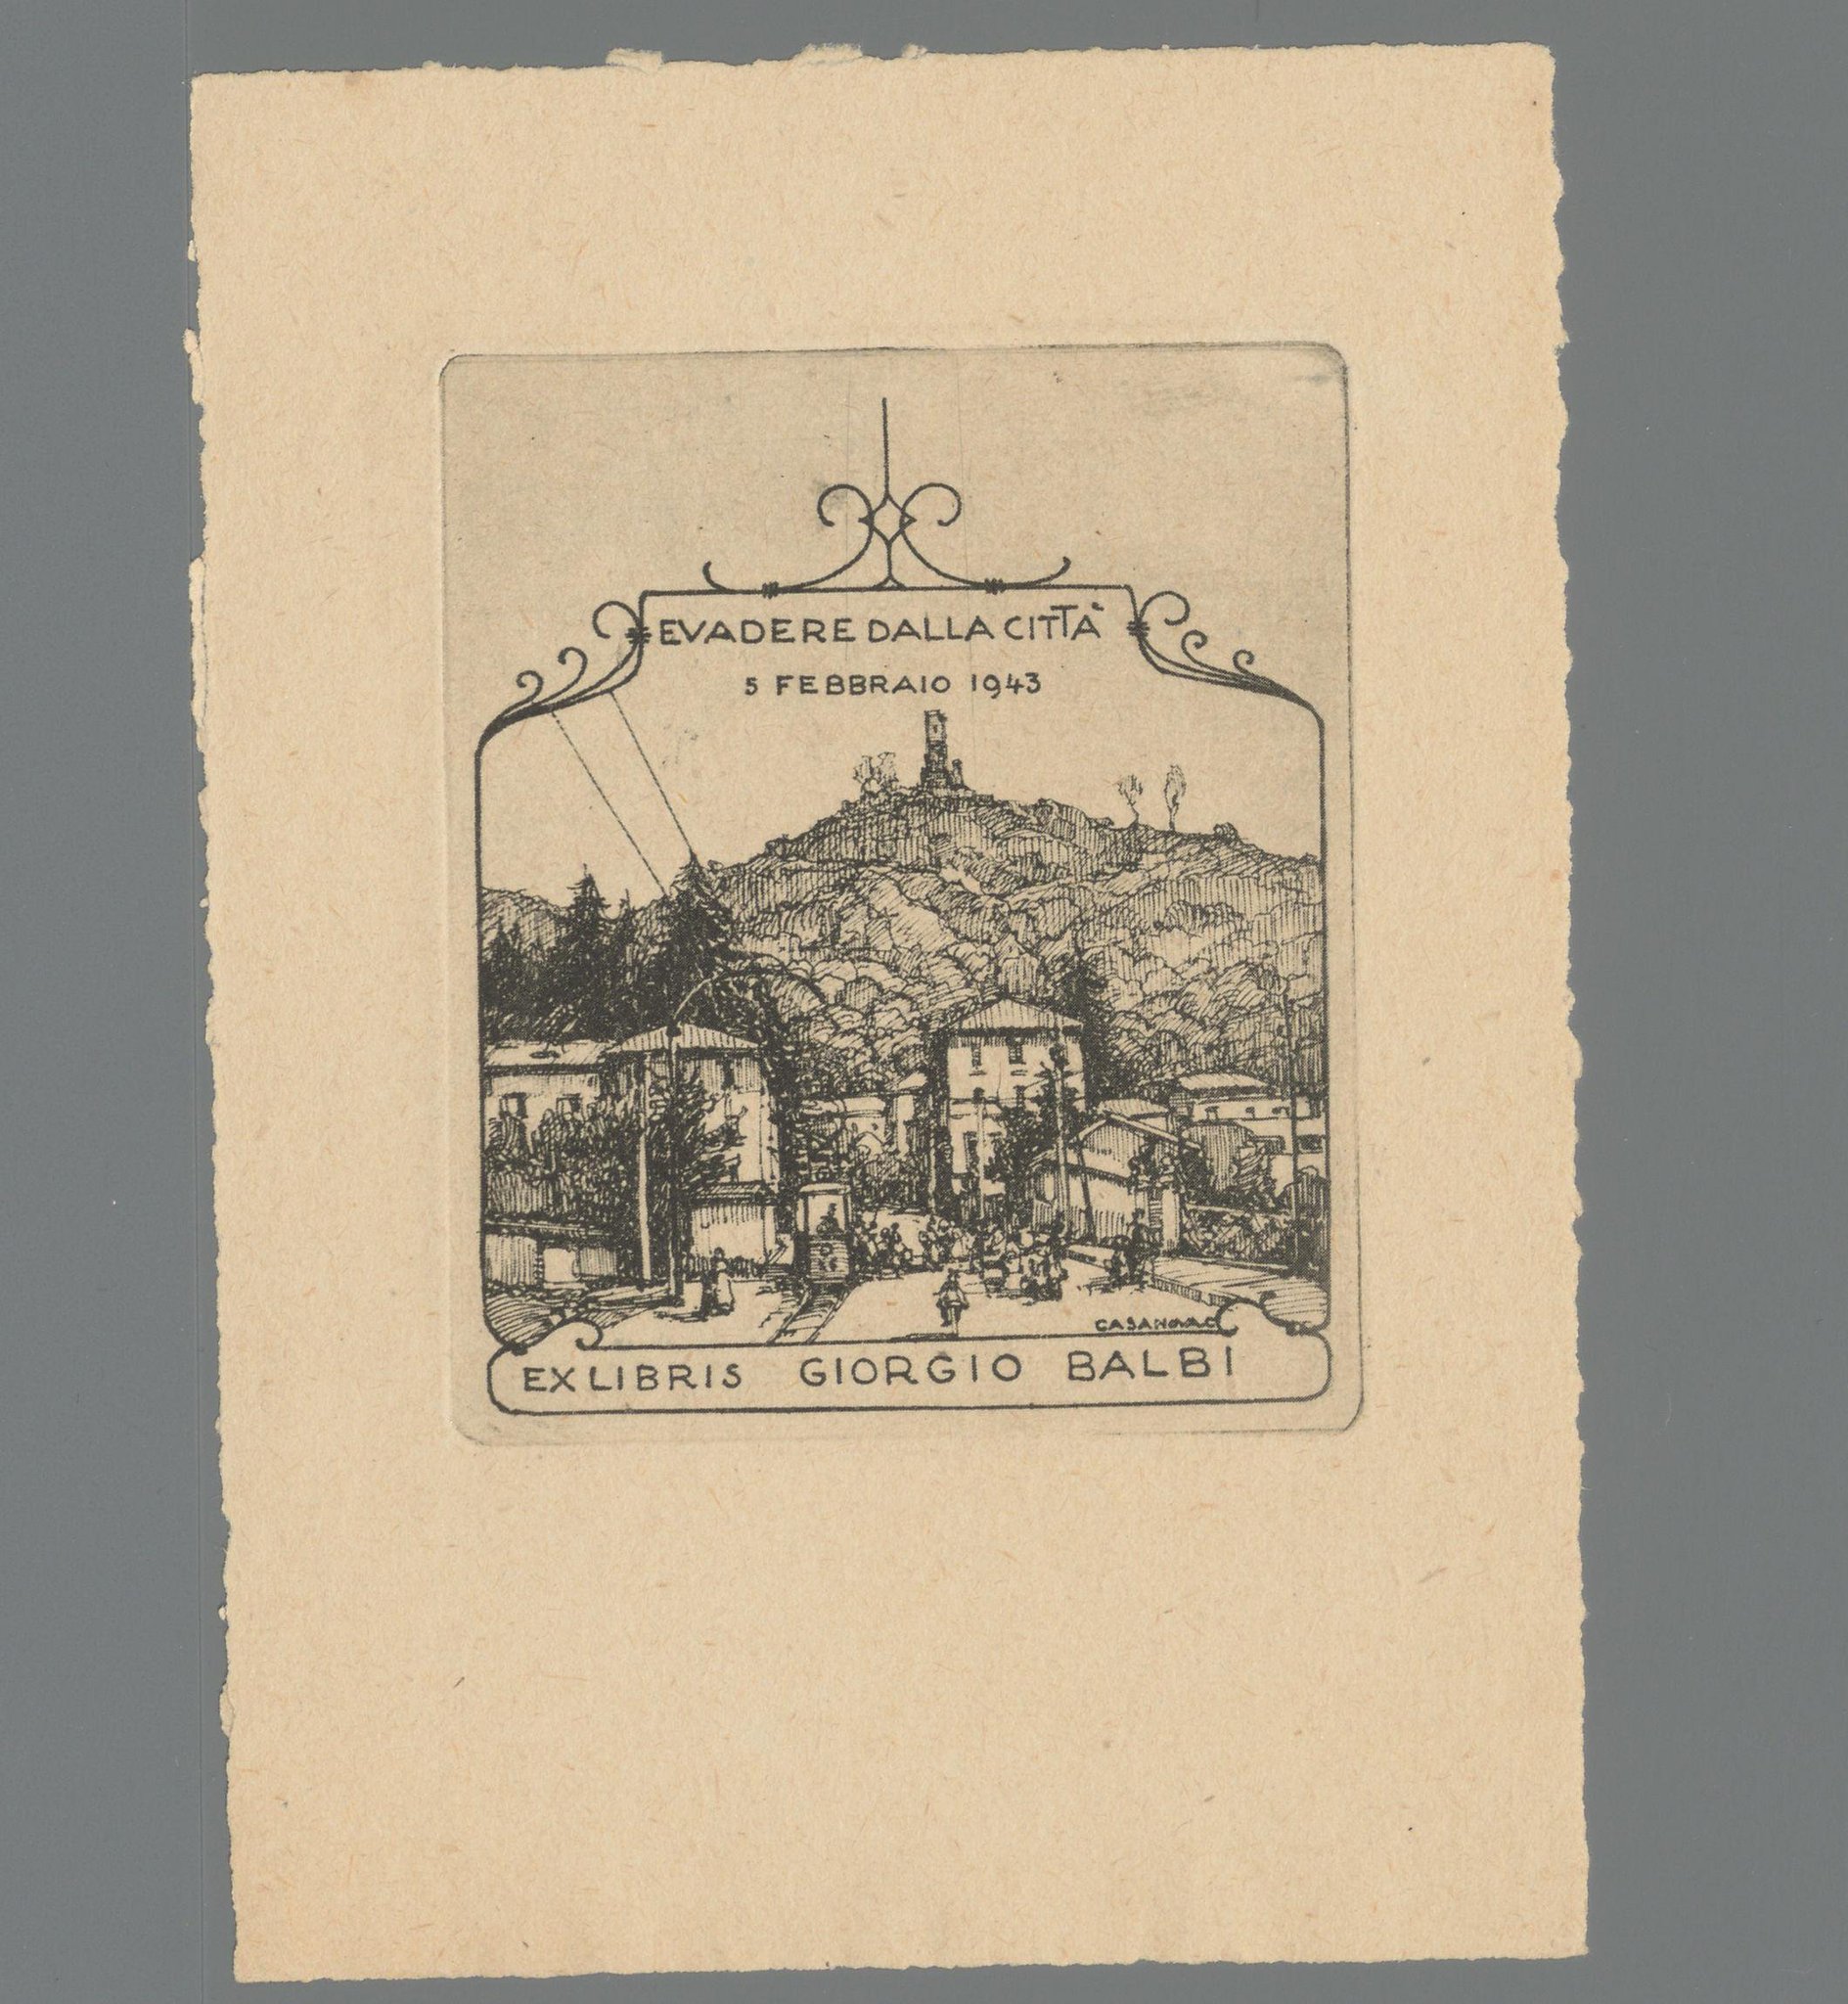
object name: bookplate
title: Ex libris van Giorgio Balbi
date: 1944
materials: paper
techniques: printing block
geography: italy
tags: gate, entrance, prospect of city, town panorama, silhouette of city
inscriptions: inscription: ‘Carlo Casanova 1944 / (view of Como)’